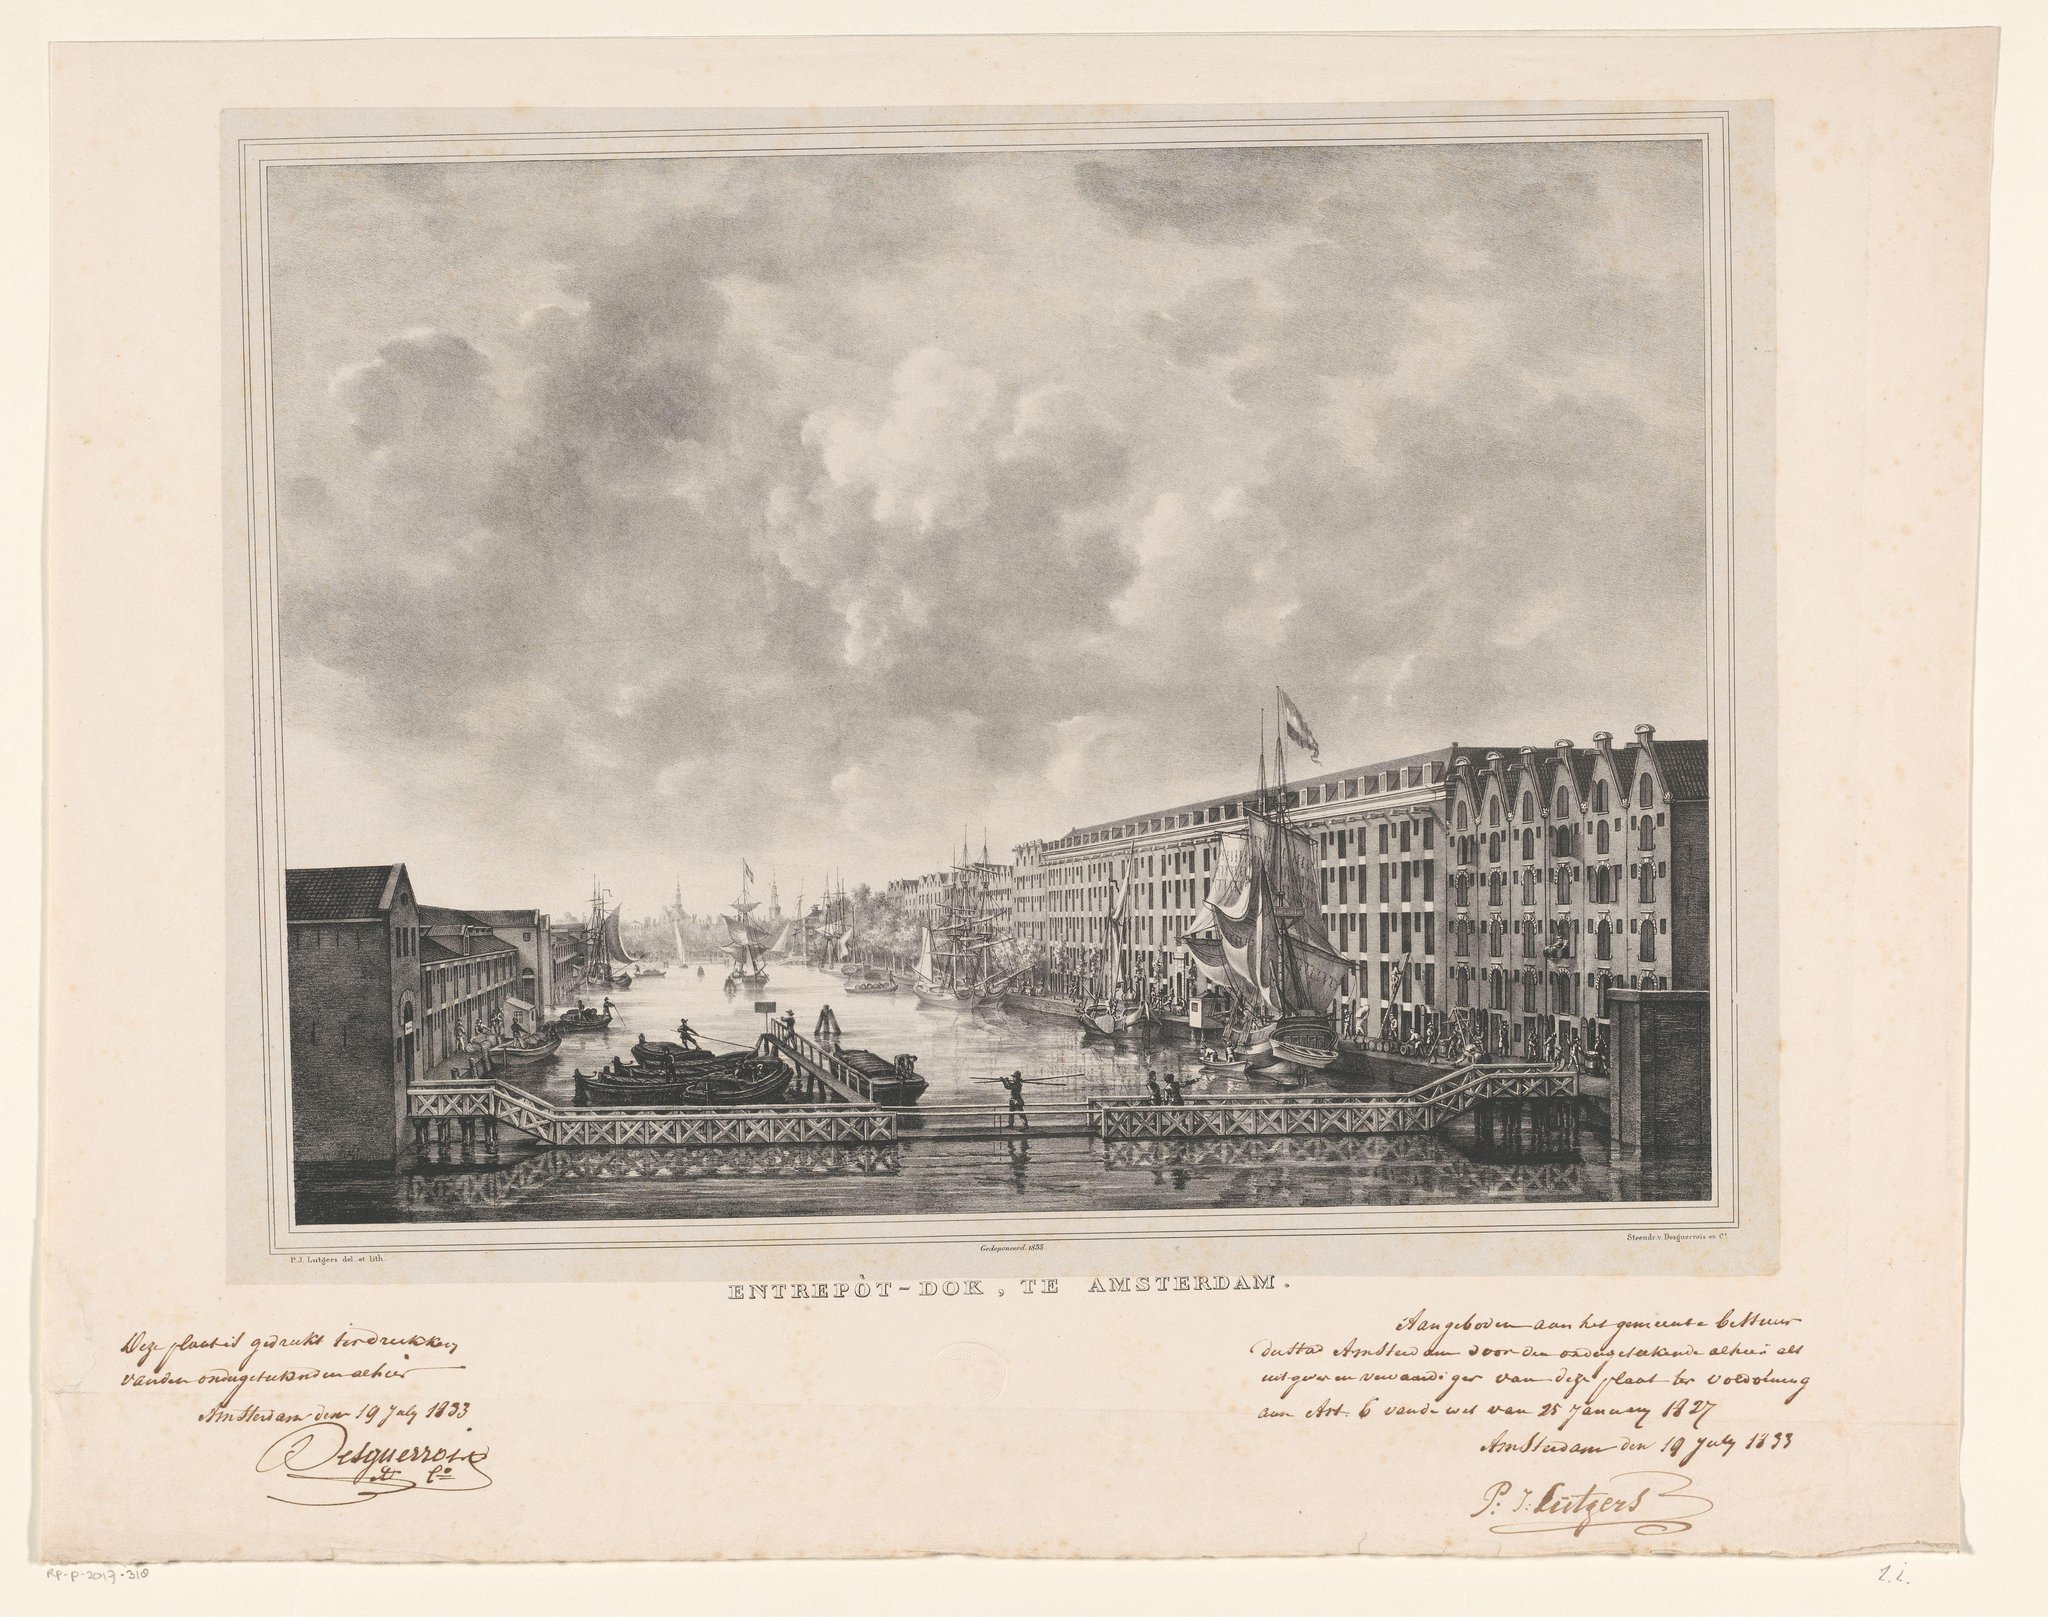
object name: print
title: Entrepòt-dok, te Amsterdam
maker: petrus josephus lutgers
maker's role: draughtsman, print maker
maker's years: 1808-1874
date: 1833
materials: paper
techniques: lithograph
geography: amsterdam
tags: sluice, weir, large-scale structure for storage, e.g.: warehouse, depot, silo, ships (in general), parts of church exterior and annexes: tower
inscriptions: : ‘Deze plaat is gedrukt ter drukkerij / van den ondergetekenden / Amsterdam den 19 july 1833 / Desguerrois&Co’, : ‘Gedeponeerd 1833.’, : ‘Aangeboden aan het gemeentebestuur / der stad Amsterdam door den ondergetekende alhier als / uitgever en vervaardiger van deze plaat ter voldoening / aan Art. 6 van de wet van 25 january 1817 / Amsterdam den 19 july 1833 / P.J. Lutgers’, collector's mark: Lugt 2228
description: Gezien vanaf de sluis richting het westen. Rechts de pakhuizen. Op het water liggen boten en zeilschepen. Aan de horizon de Montelbaanstoren en de toren van de Zuiderkerk.